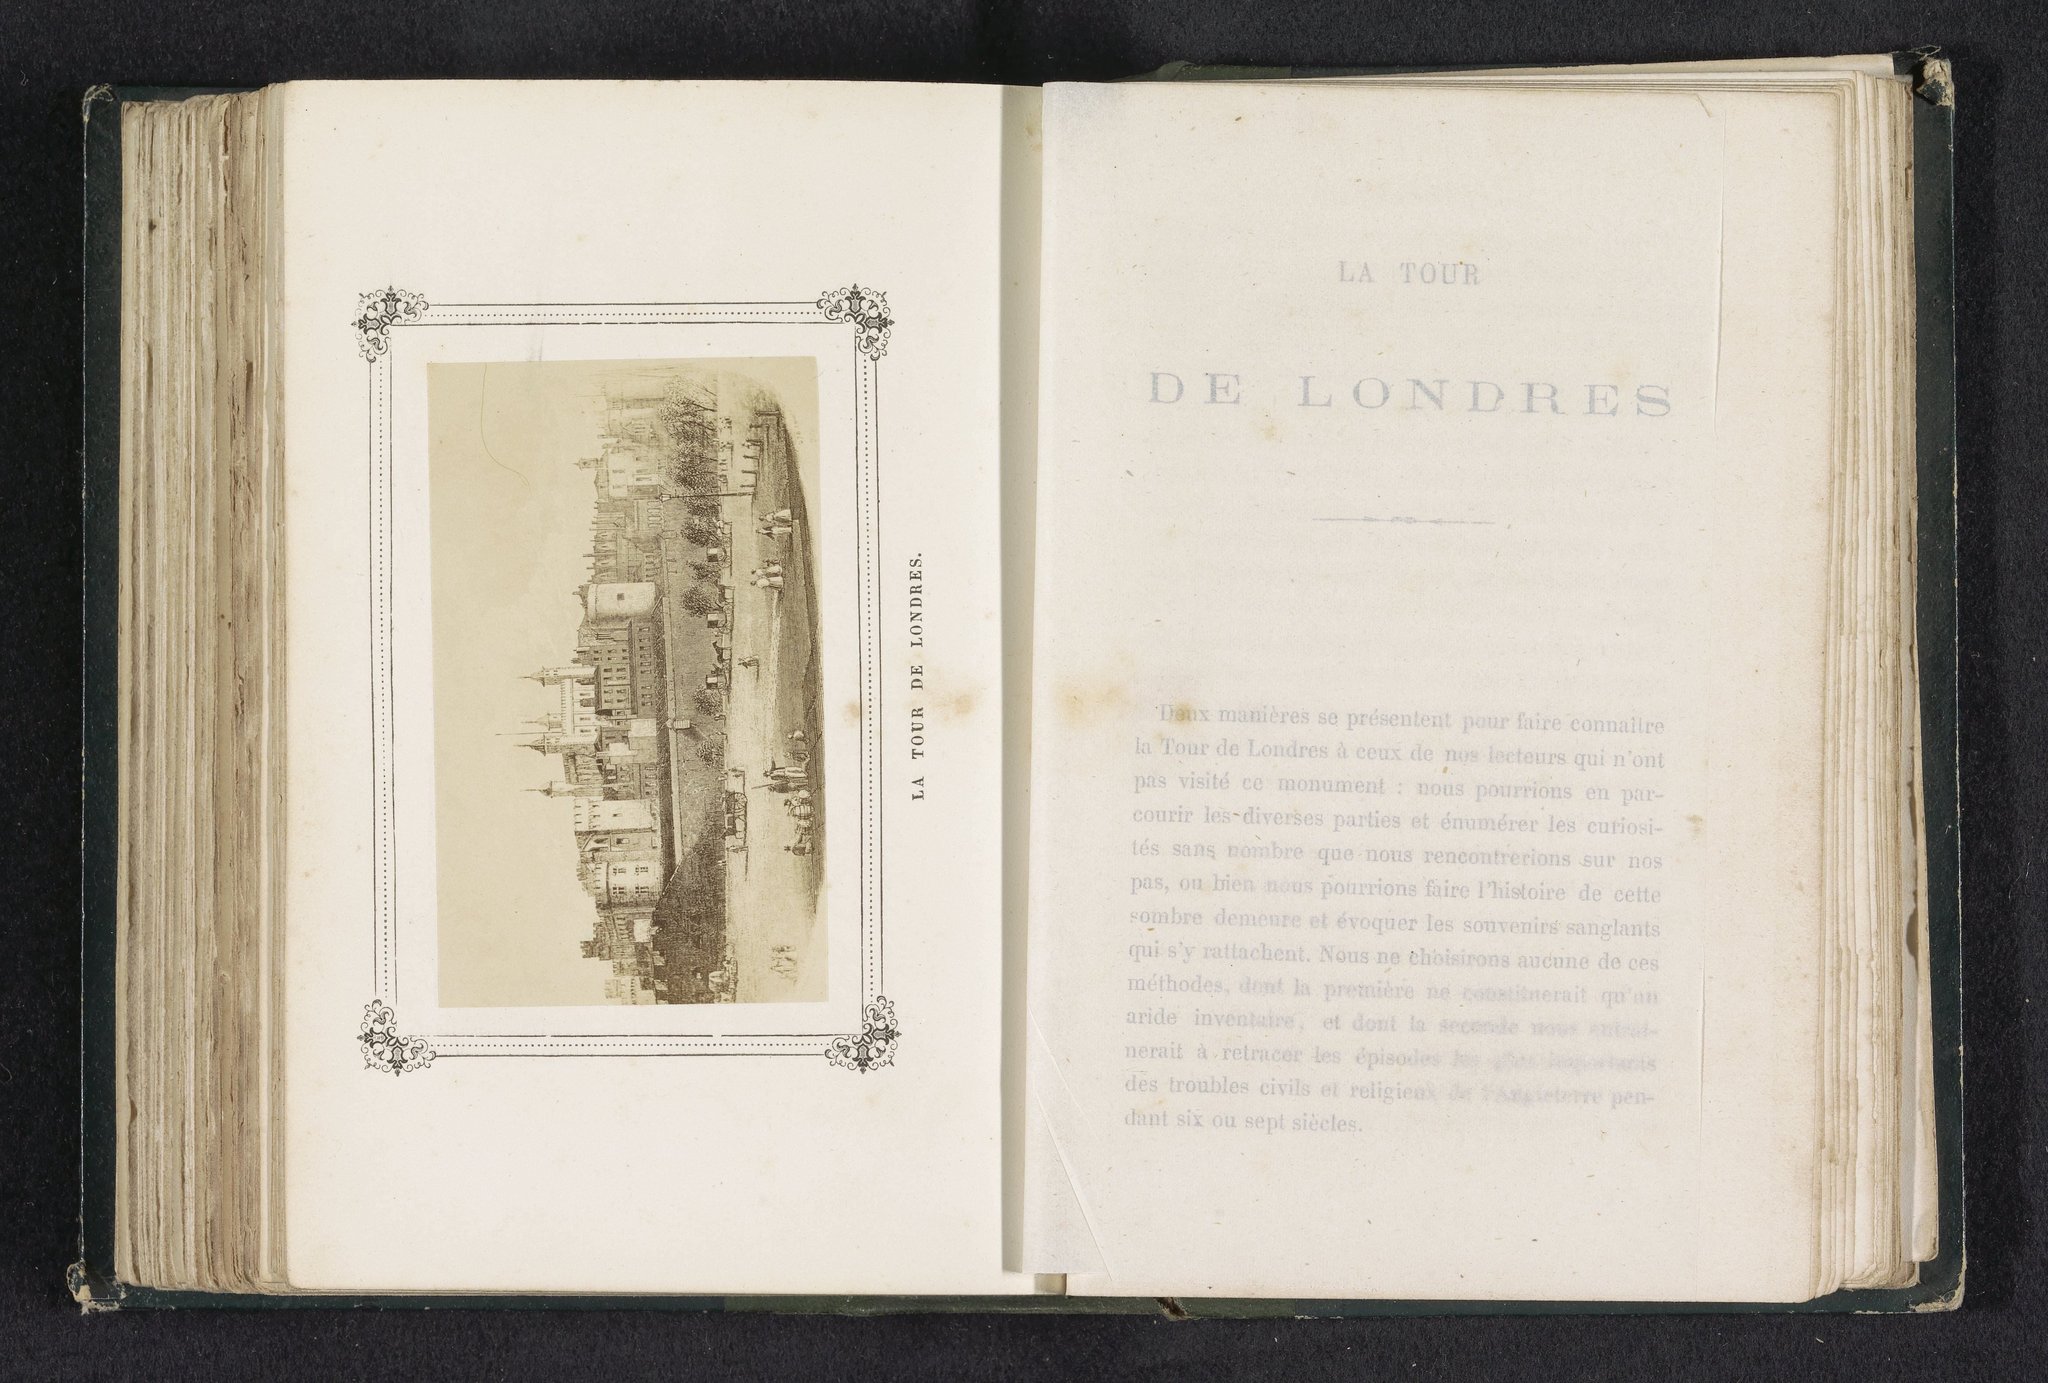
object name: photograph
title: Fotoreproductie van een tekening, voorstellende een gezicht op de Tower of London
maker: Anonymous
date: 1853-1863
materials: photographic support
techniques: albumen print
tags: prison, jail, façade (of house or building)